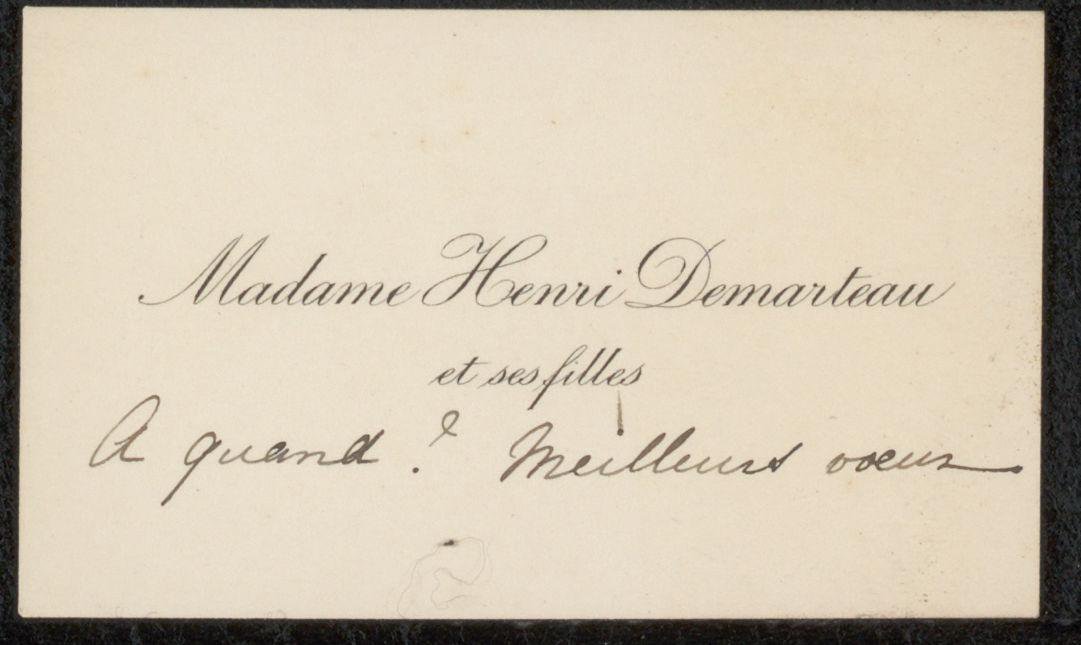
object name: visiting card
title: Visitekaartje aan Philip Zilcken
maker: mevrouw henri demarteau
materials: cardboard, ink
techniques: pen, printing, writing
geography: brussels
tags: the hague, painter, draughtsman, philip zilcken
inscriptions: collector's mark: ‘RPK’